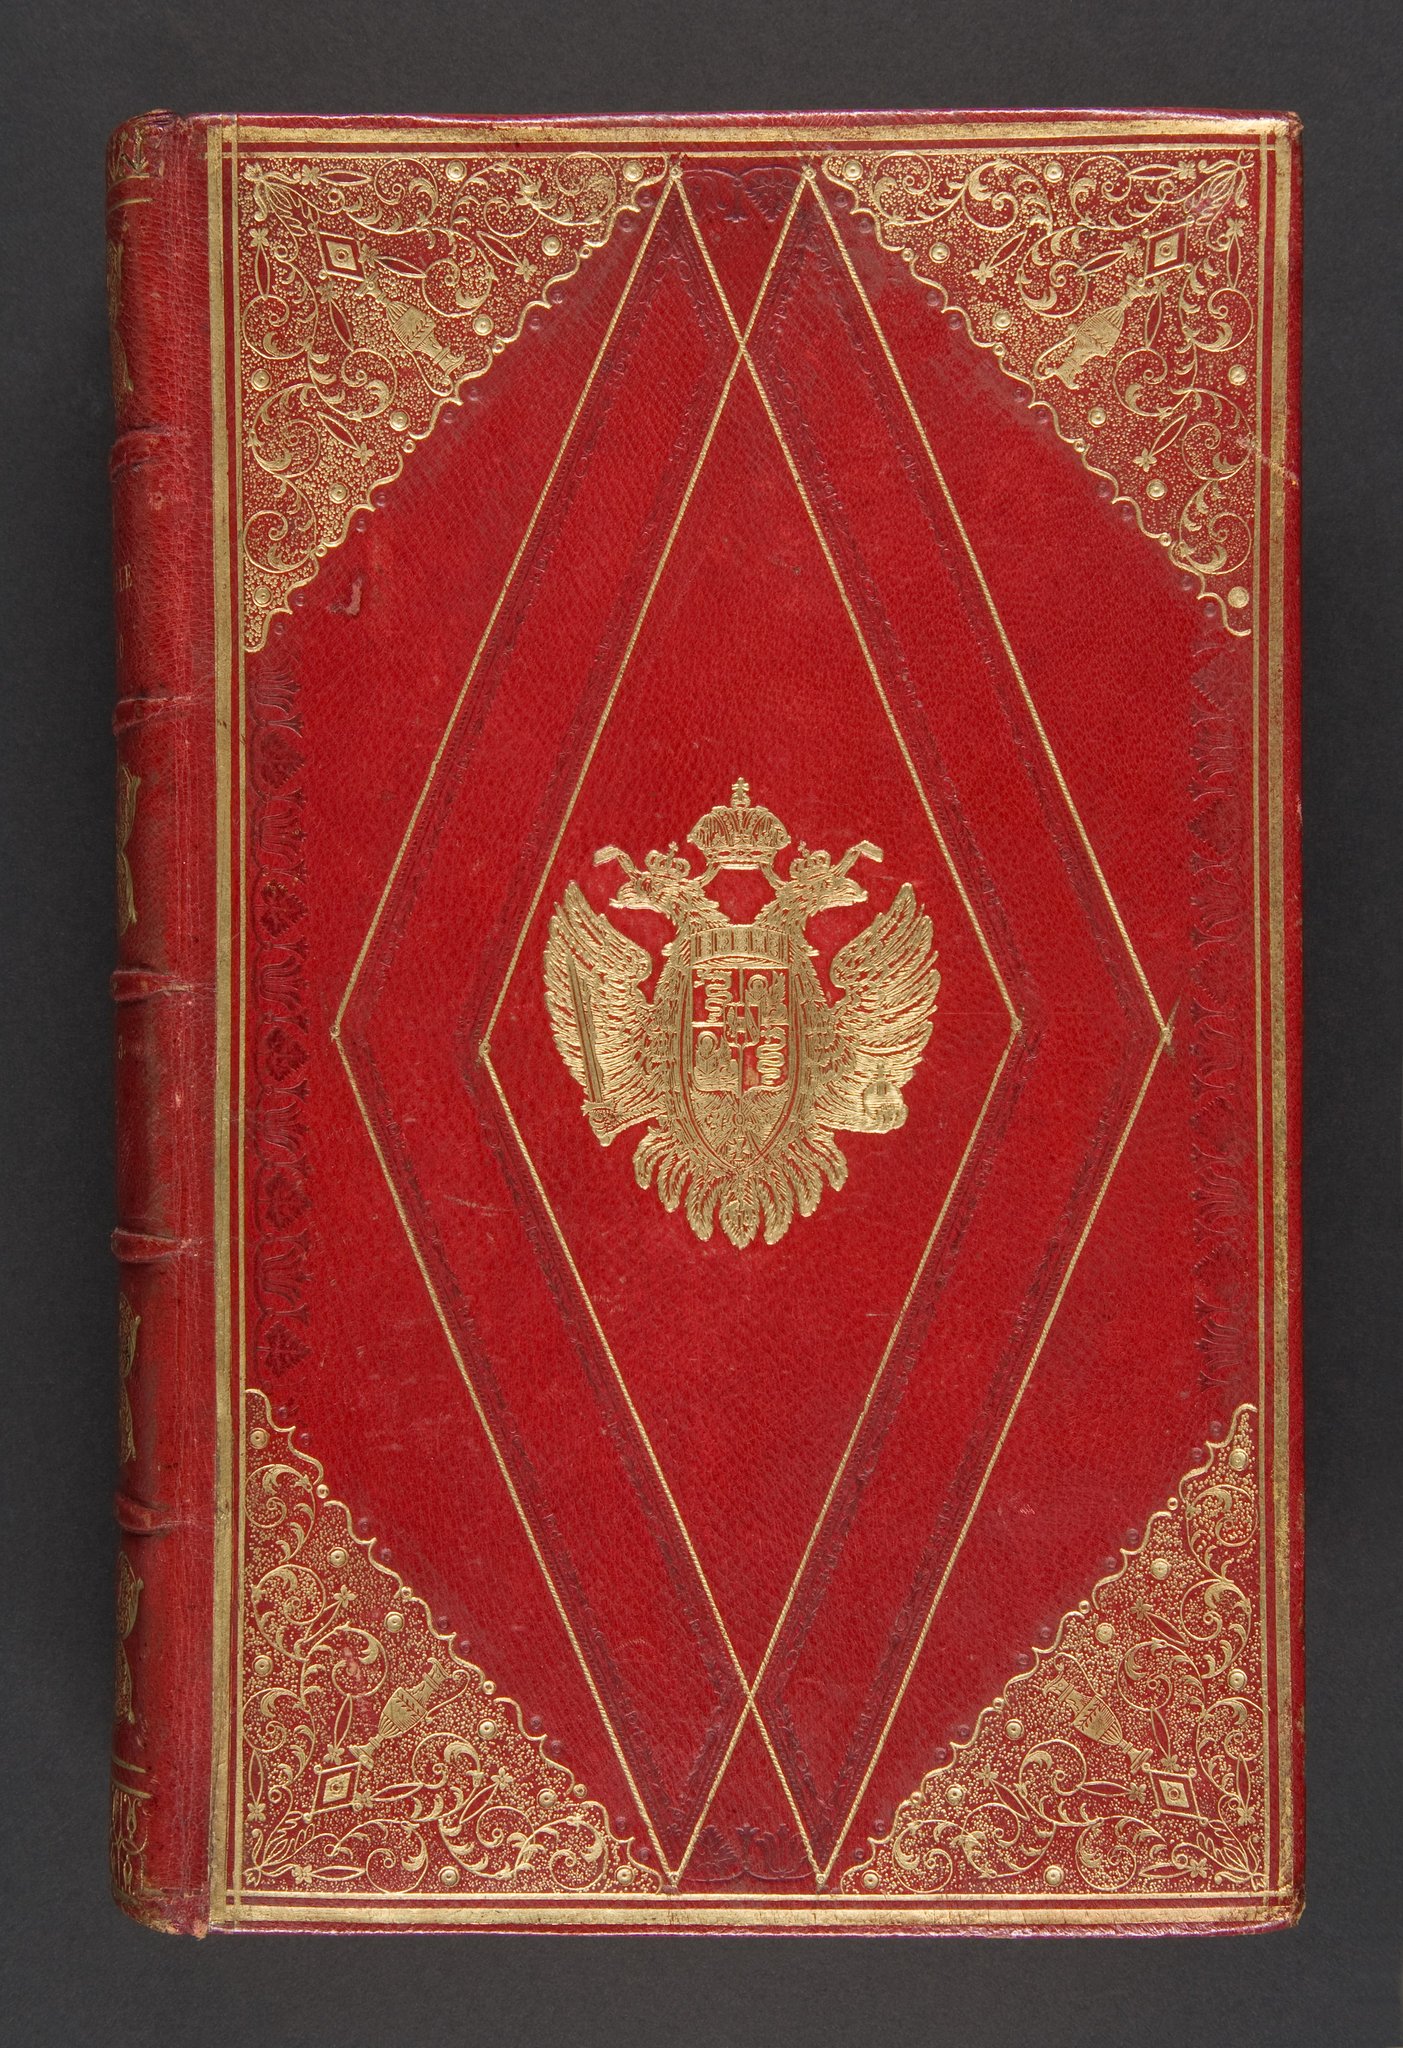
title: Codice civile generale austriaco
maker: luigi lodigiani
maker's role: binder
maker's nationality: italian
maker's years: 1778-1843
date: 1815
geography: italy